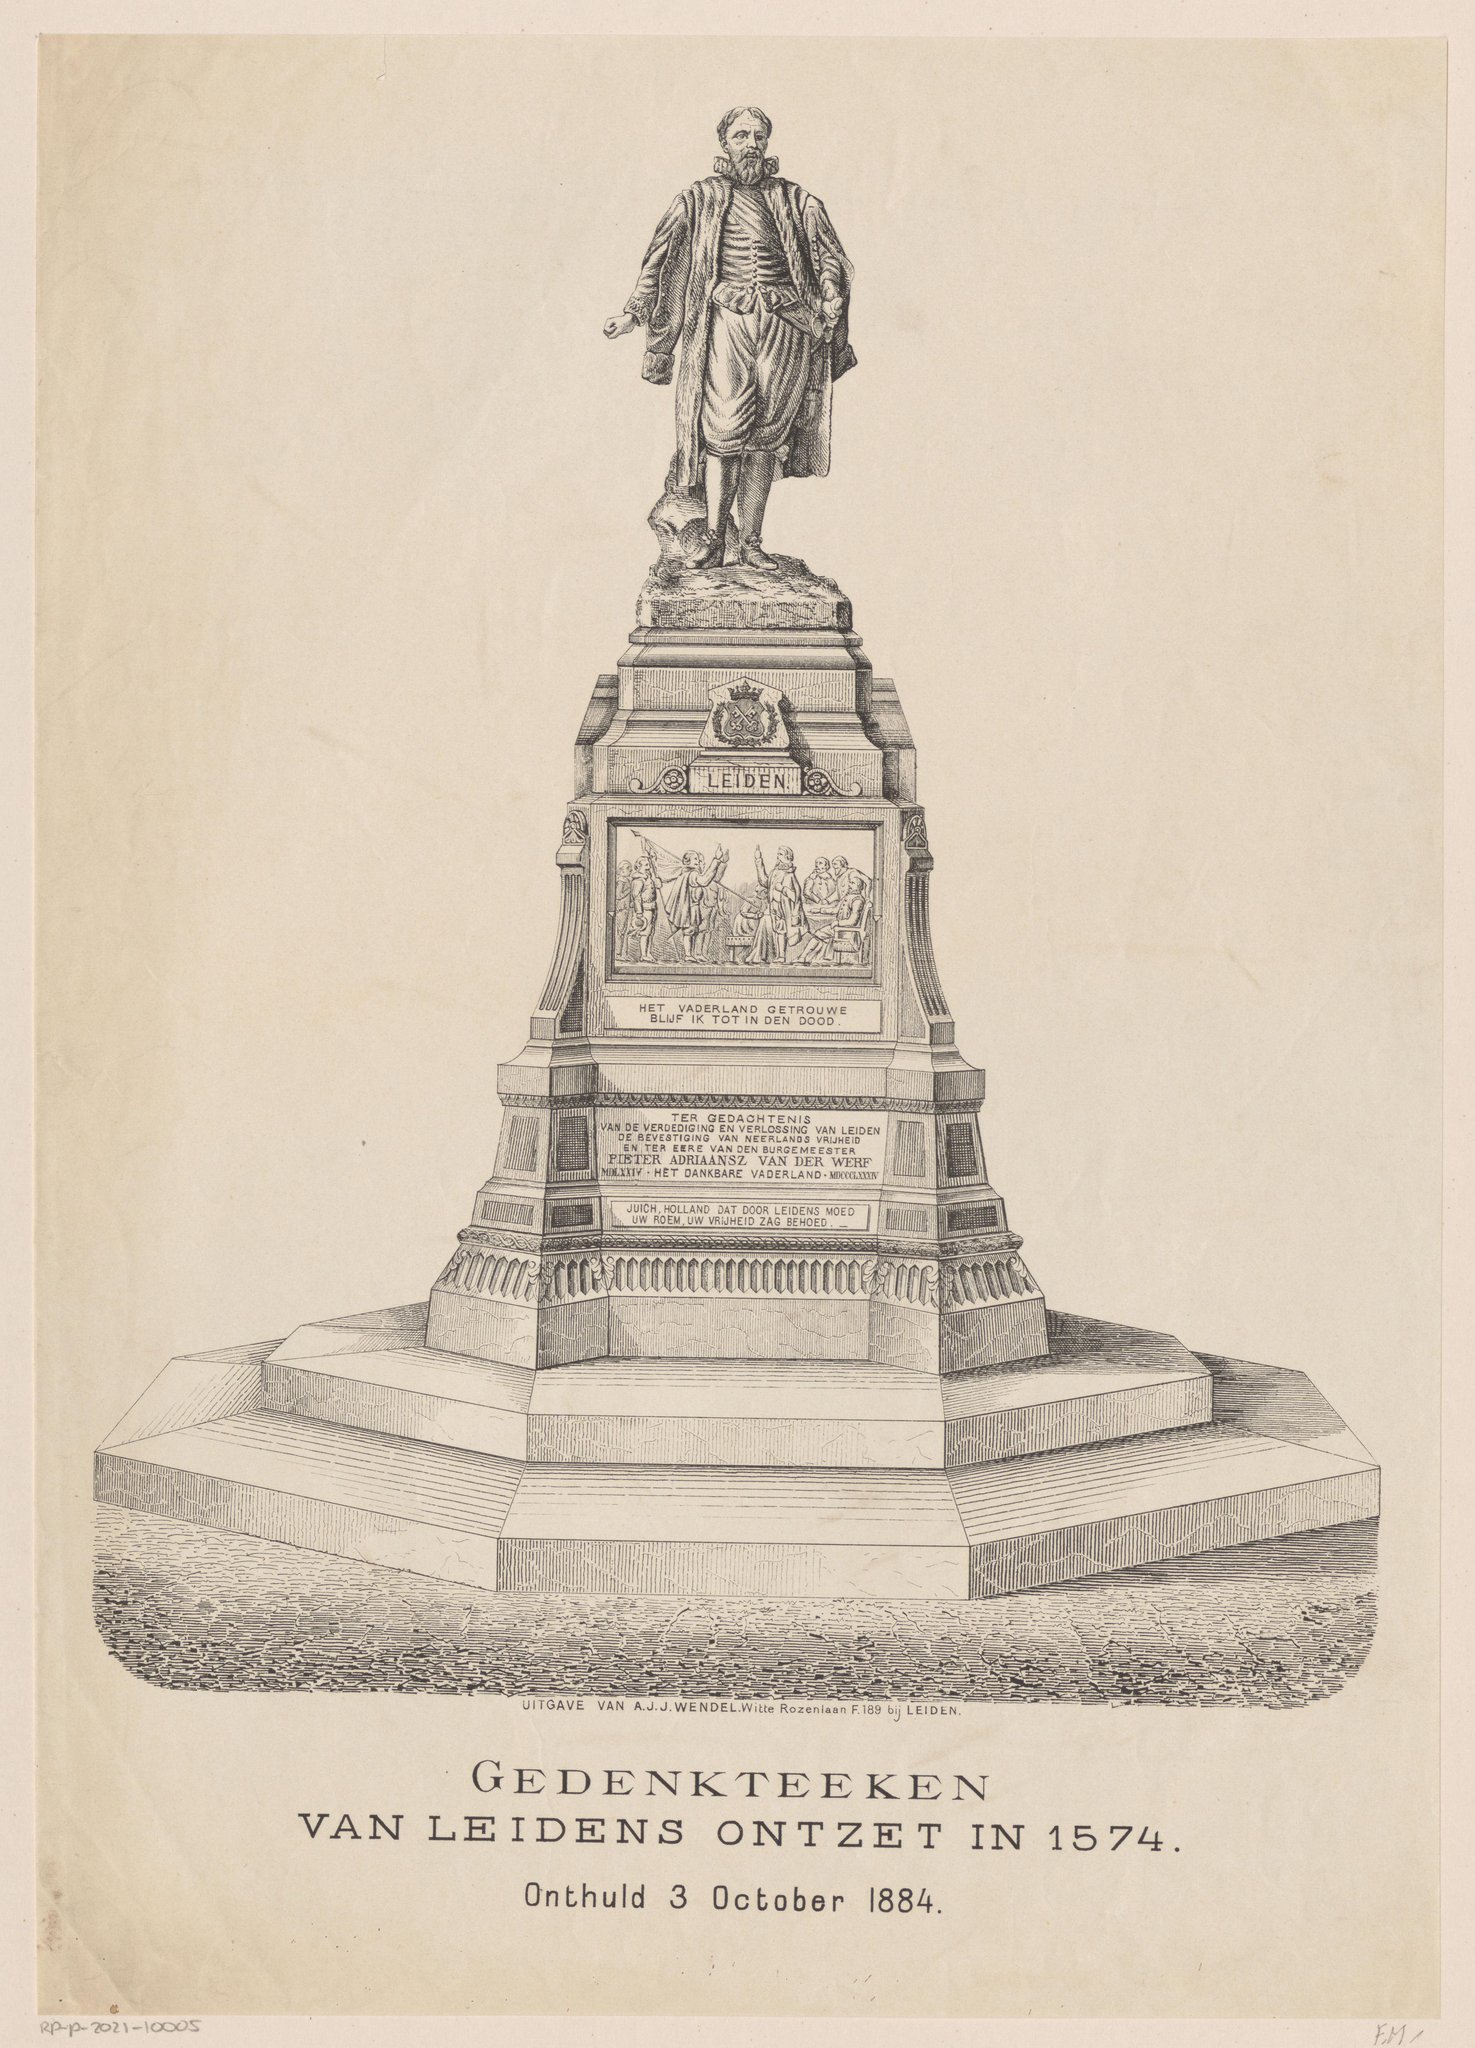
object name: print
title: Gedenkteken voor het Ontzet van Leiden in 1574 met een standbeeld van Pieter Adriaansz. van der Werff te Leiden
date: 1884-1886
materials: paper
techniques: lithograph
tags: historical persons, monument, statue, leiden